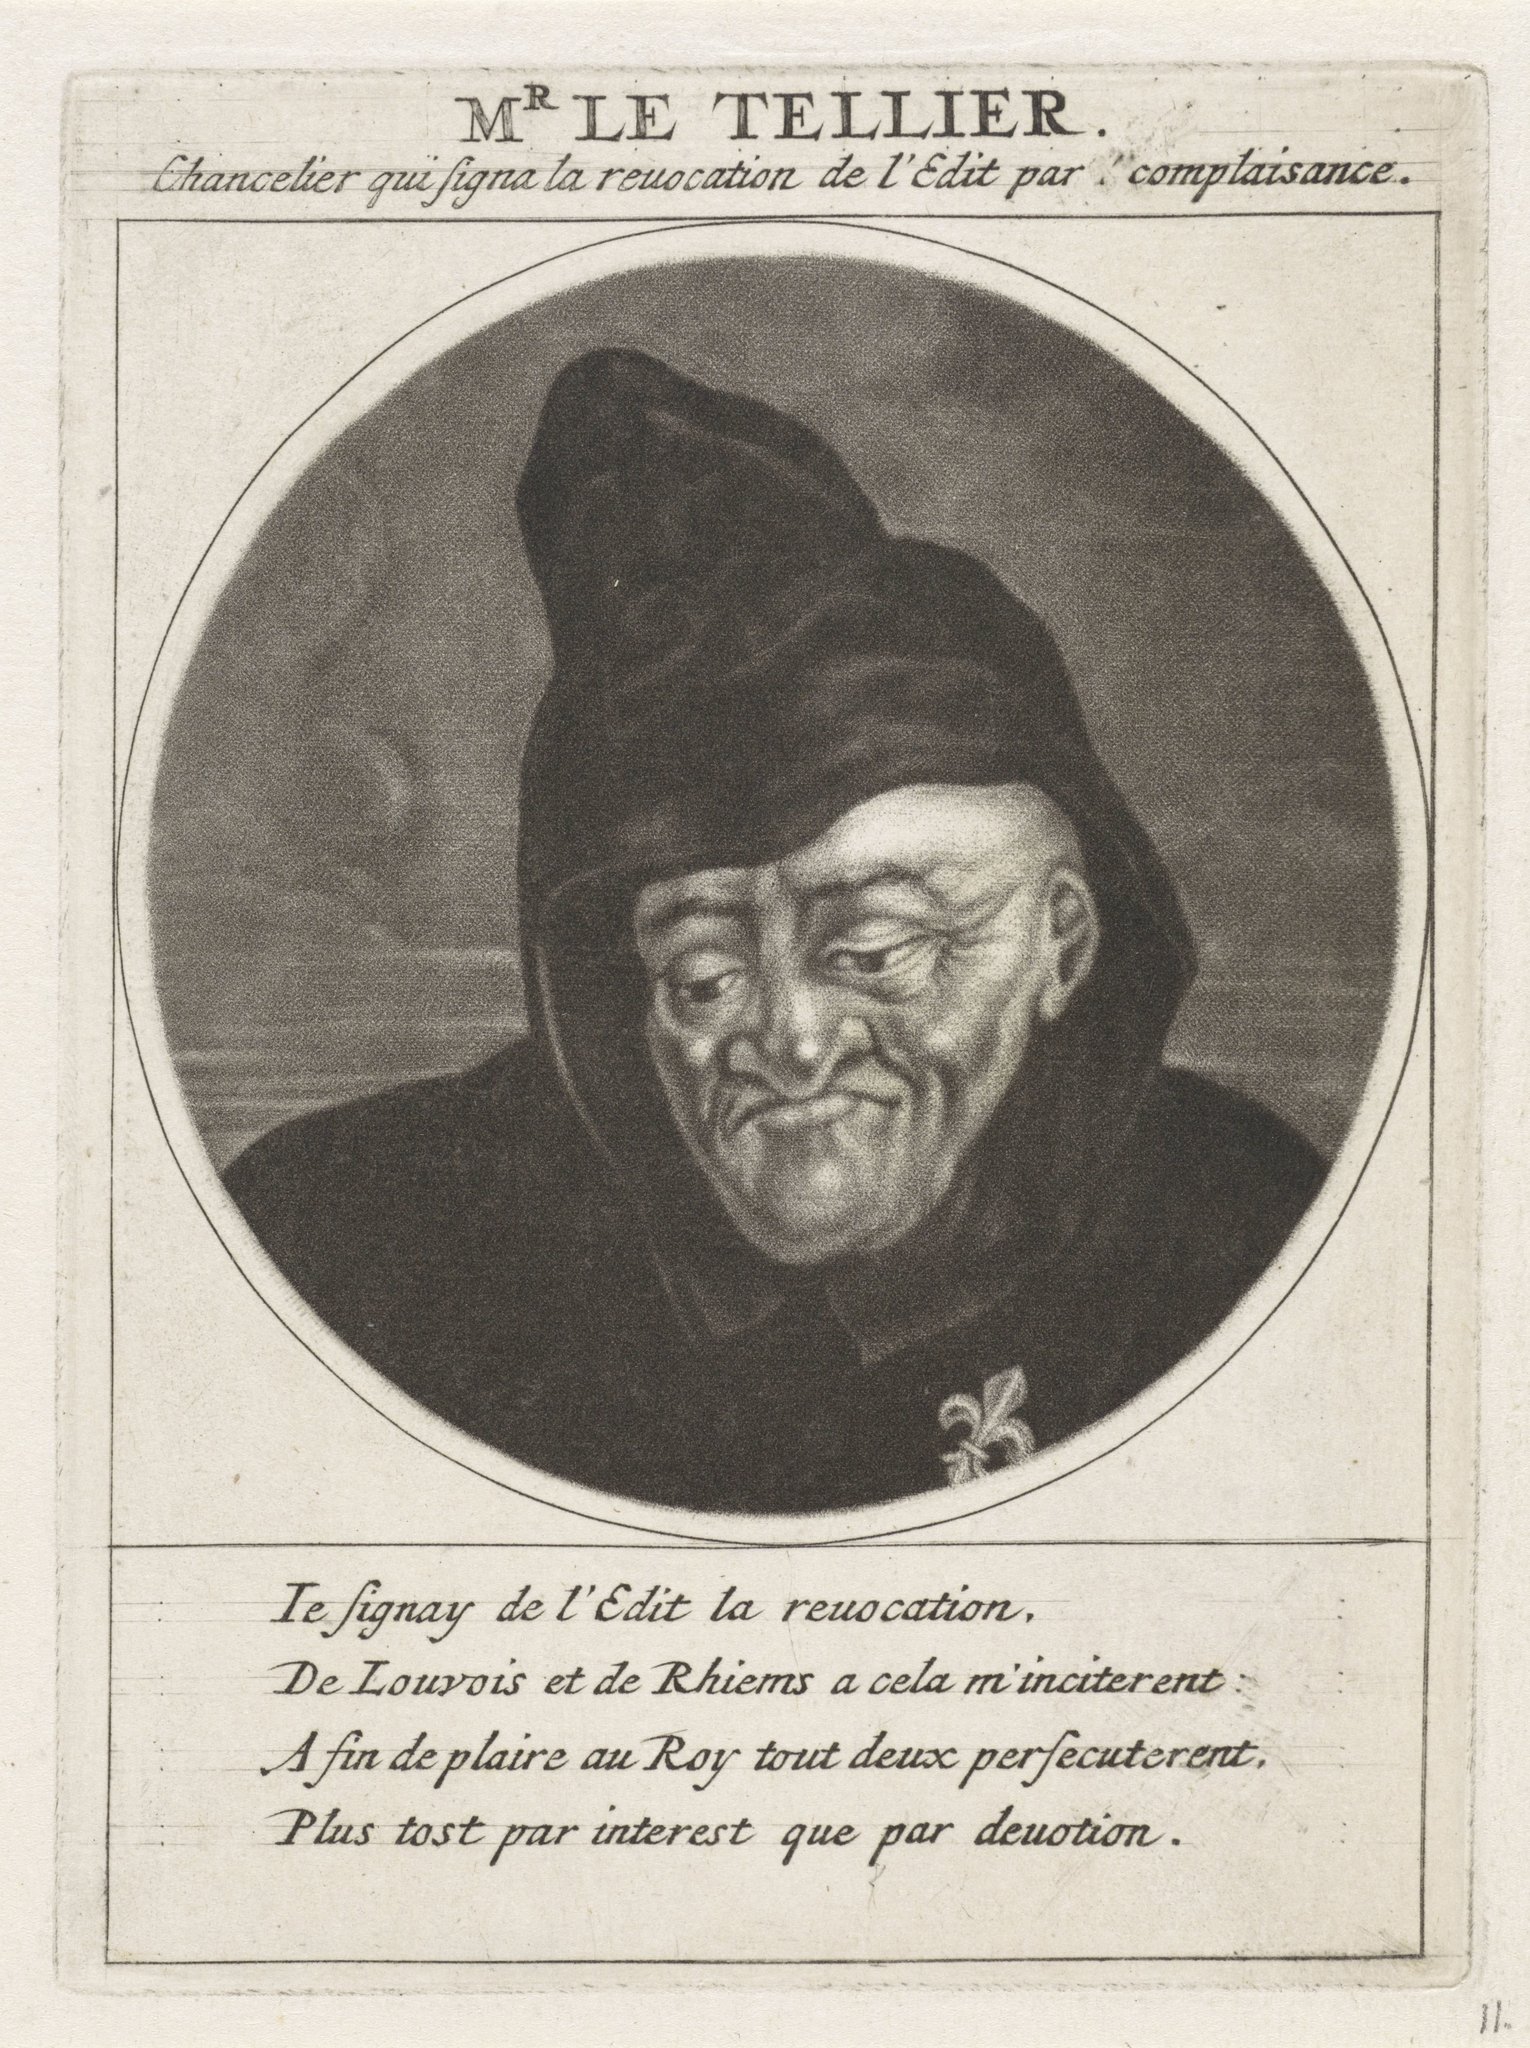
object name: print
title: Mr Le Tellier, Chancelier qui signa la revocation de l'Edit par complaisance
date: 1691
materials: paper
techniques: engraving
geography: paris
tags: paris, michel le tellier, political caricatures and satires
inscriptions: collector's mark: Lugt 240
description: Titelpagina voor: Les Heros de la Ligue: ou la procession monacale, conduitte par Louis XIV, pour la conversion des Protestants de son royaume. Chez. Pere Peters en Louis le Grand: Parijs, 1691. (De uitgevers zijn fictief.)